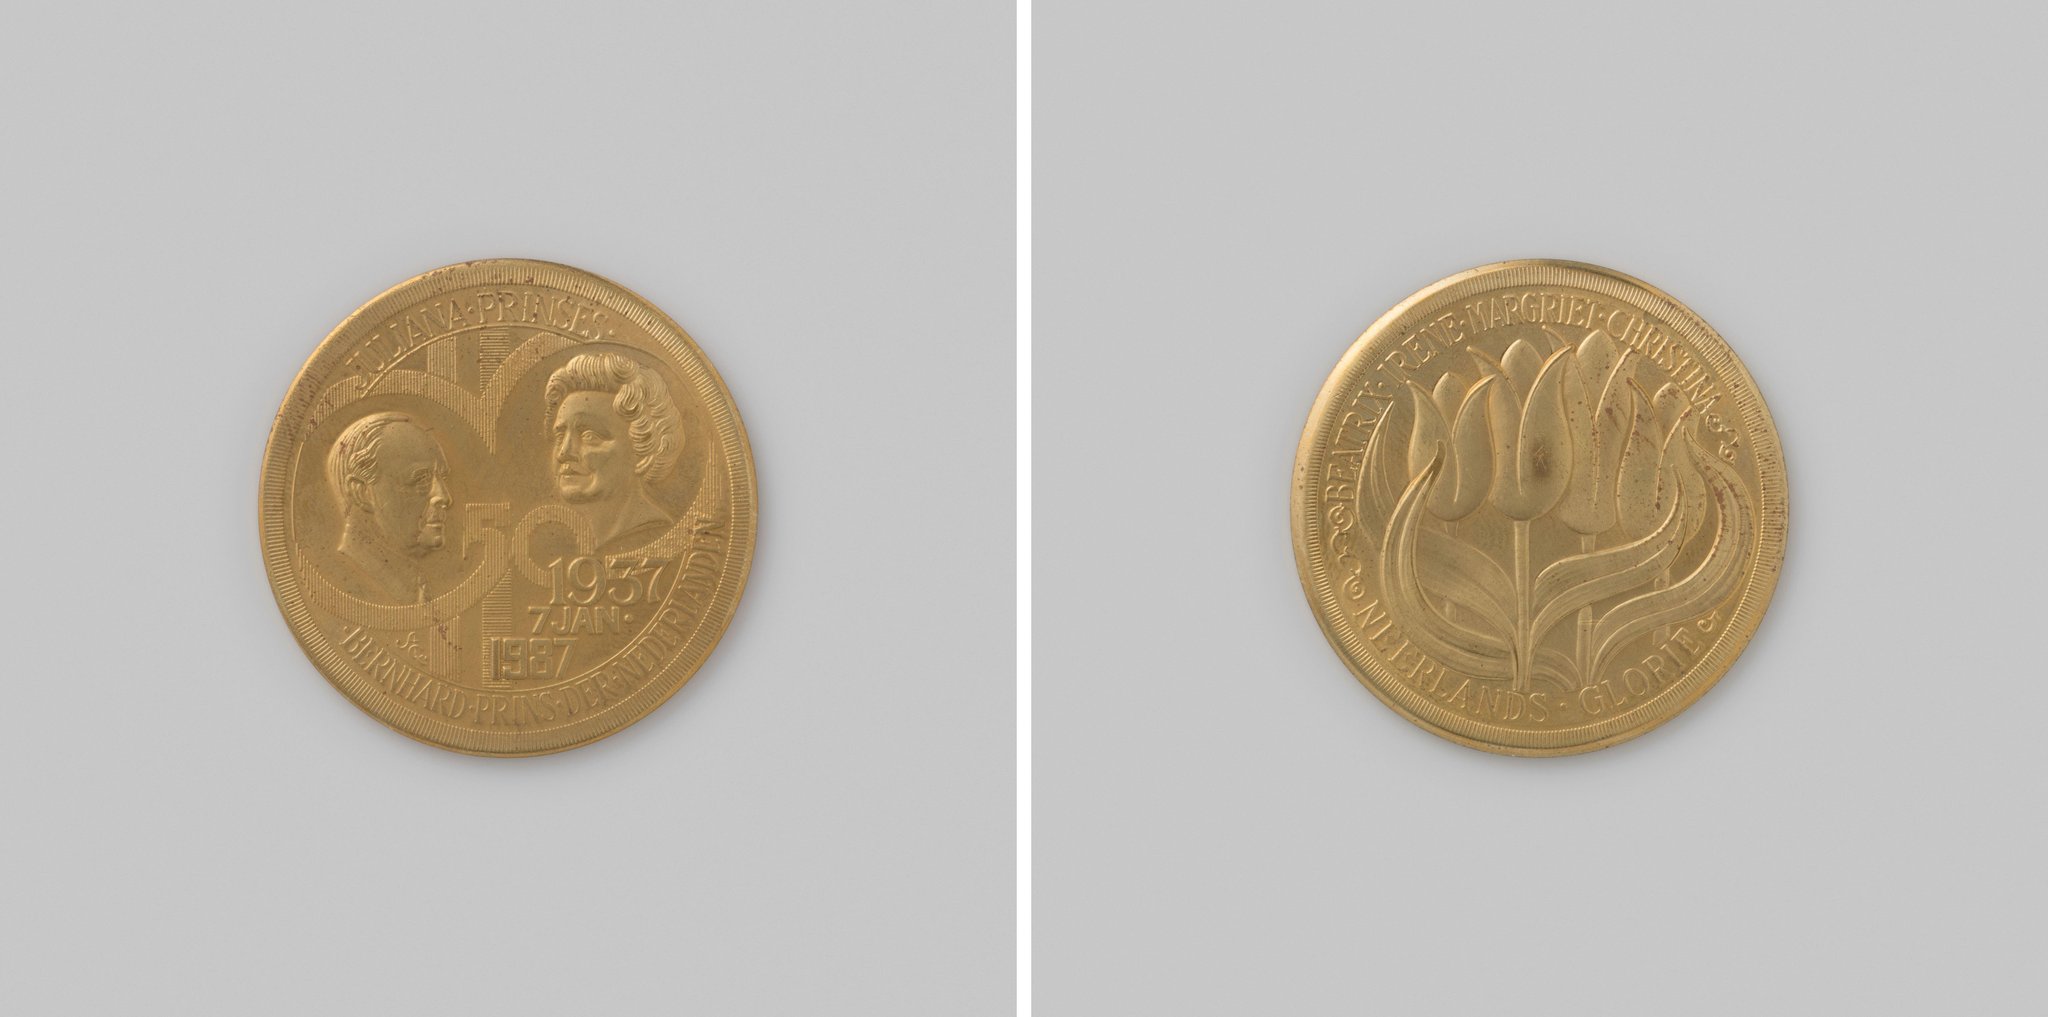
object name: family medal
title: Vijftigjarig huwelijk van Juliana en Bernhard, prinses en prins der Nederlanden, penning geslagen door de Nederlandse Vereniging van Munthandelaren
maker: a. claessen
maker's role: die cutter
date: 1987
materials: brass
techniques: striking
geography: netherlands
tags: utrecht, bernhard (prins der nederlanden), beatrix (koningin der nederlanden), the hague, juliana of the netherlands, netherlands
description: Messing penning. Voorzijde: portretten van man en vrouw in gearceerde cirkels, die eindigen in getal 50 boven opschrift, binnen omschrift. Keerzijde: vier tulpen binnen omschrift